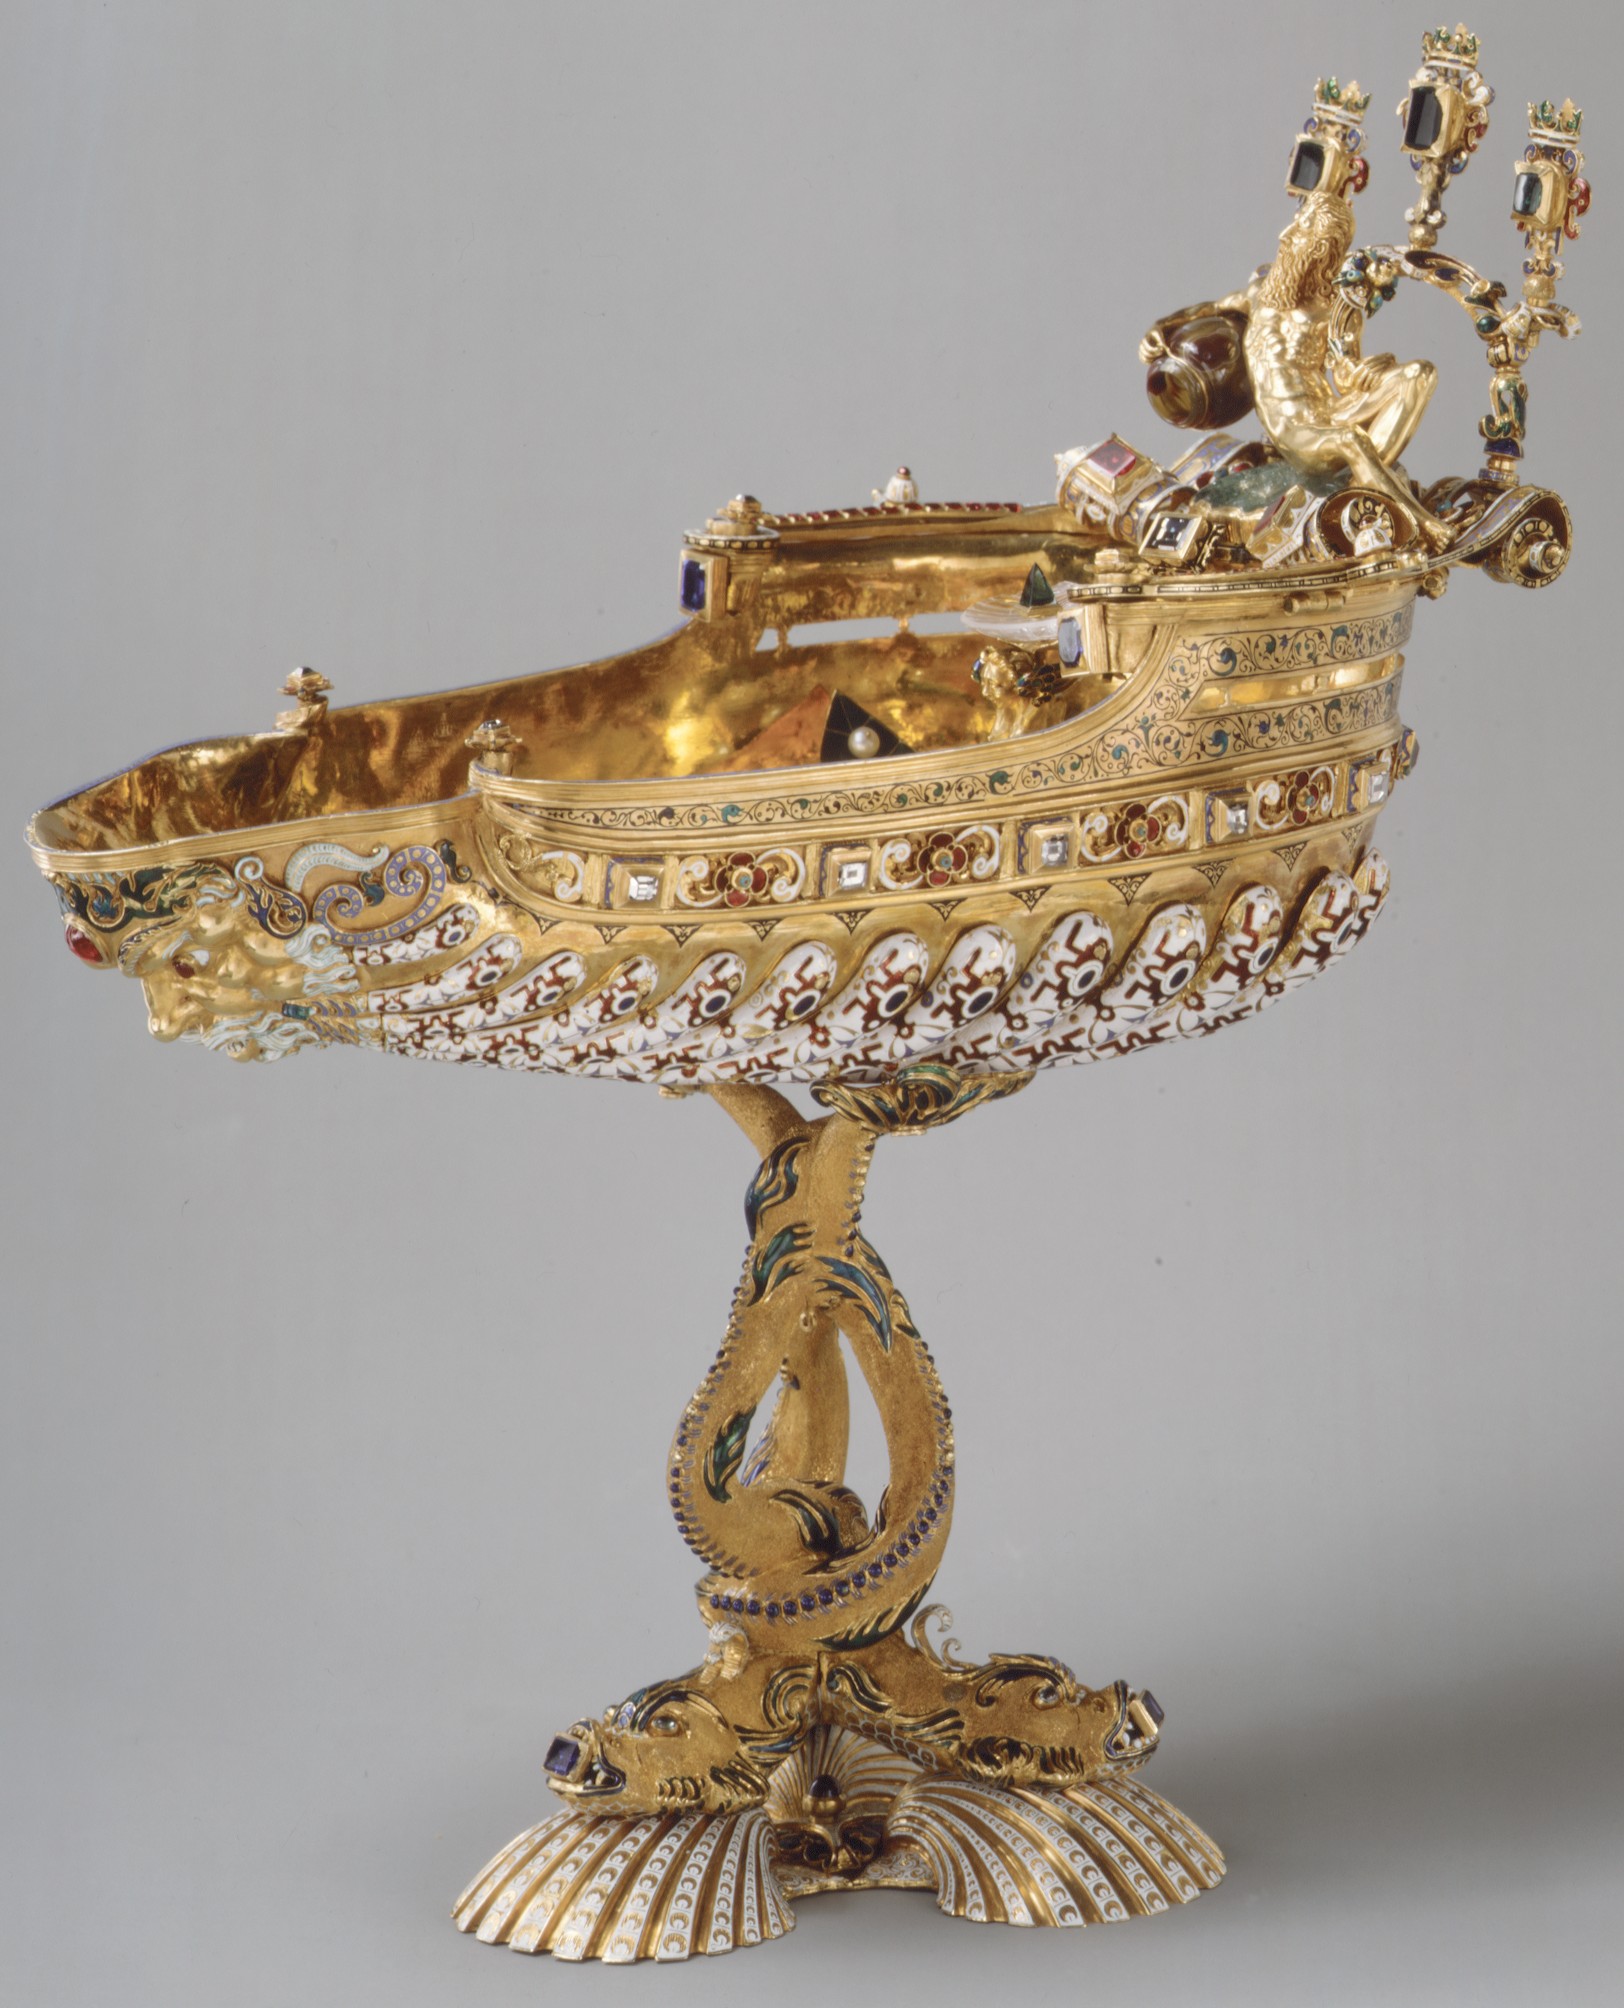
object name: cup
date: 1851-1900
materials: diamond, gemstone, glass, gold, pearl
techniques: enamel